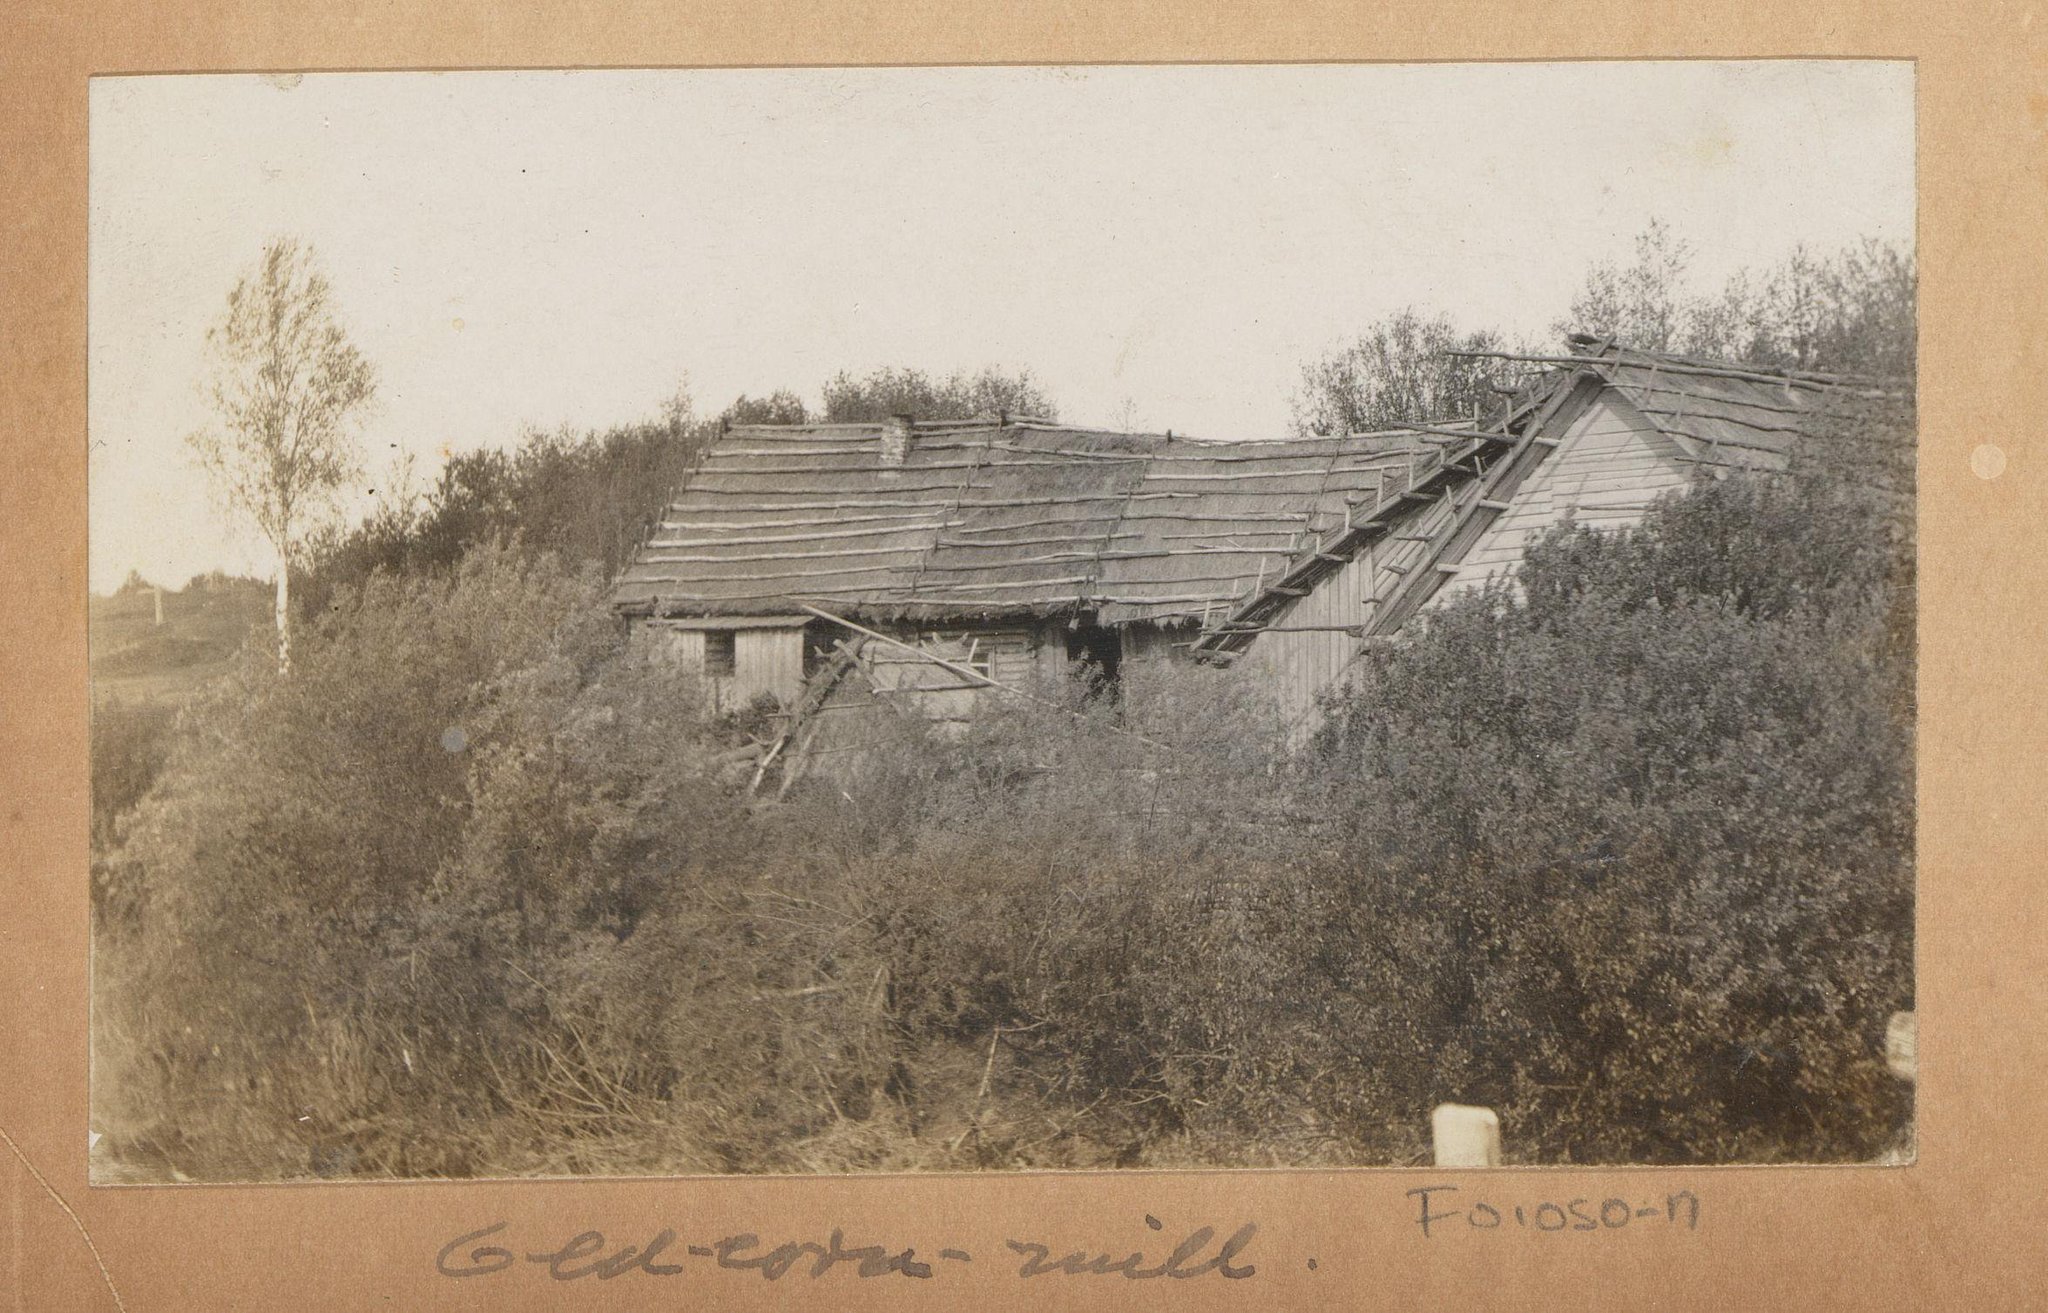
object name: photograph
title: Oude korenmolen in Rusland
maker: joseph cheetham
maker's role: engineer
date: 1903-1904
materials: photographic support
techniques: gelatin silver print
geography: russia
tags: workshop, grinding, milling (industrial processes), russia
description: Onderdeel van Fotoalbum van de Engelse familie Cheetham met opnames van hun verblijf in Rusland.